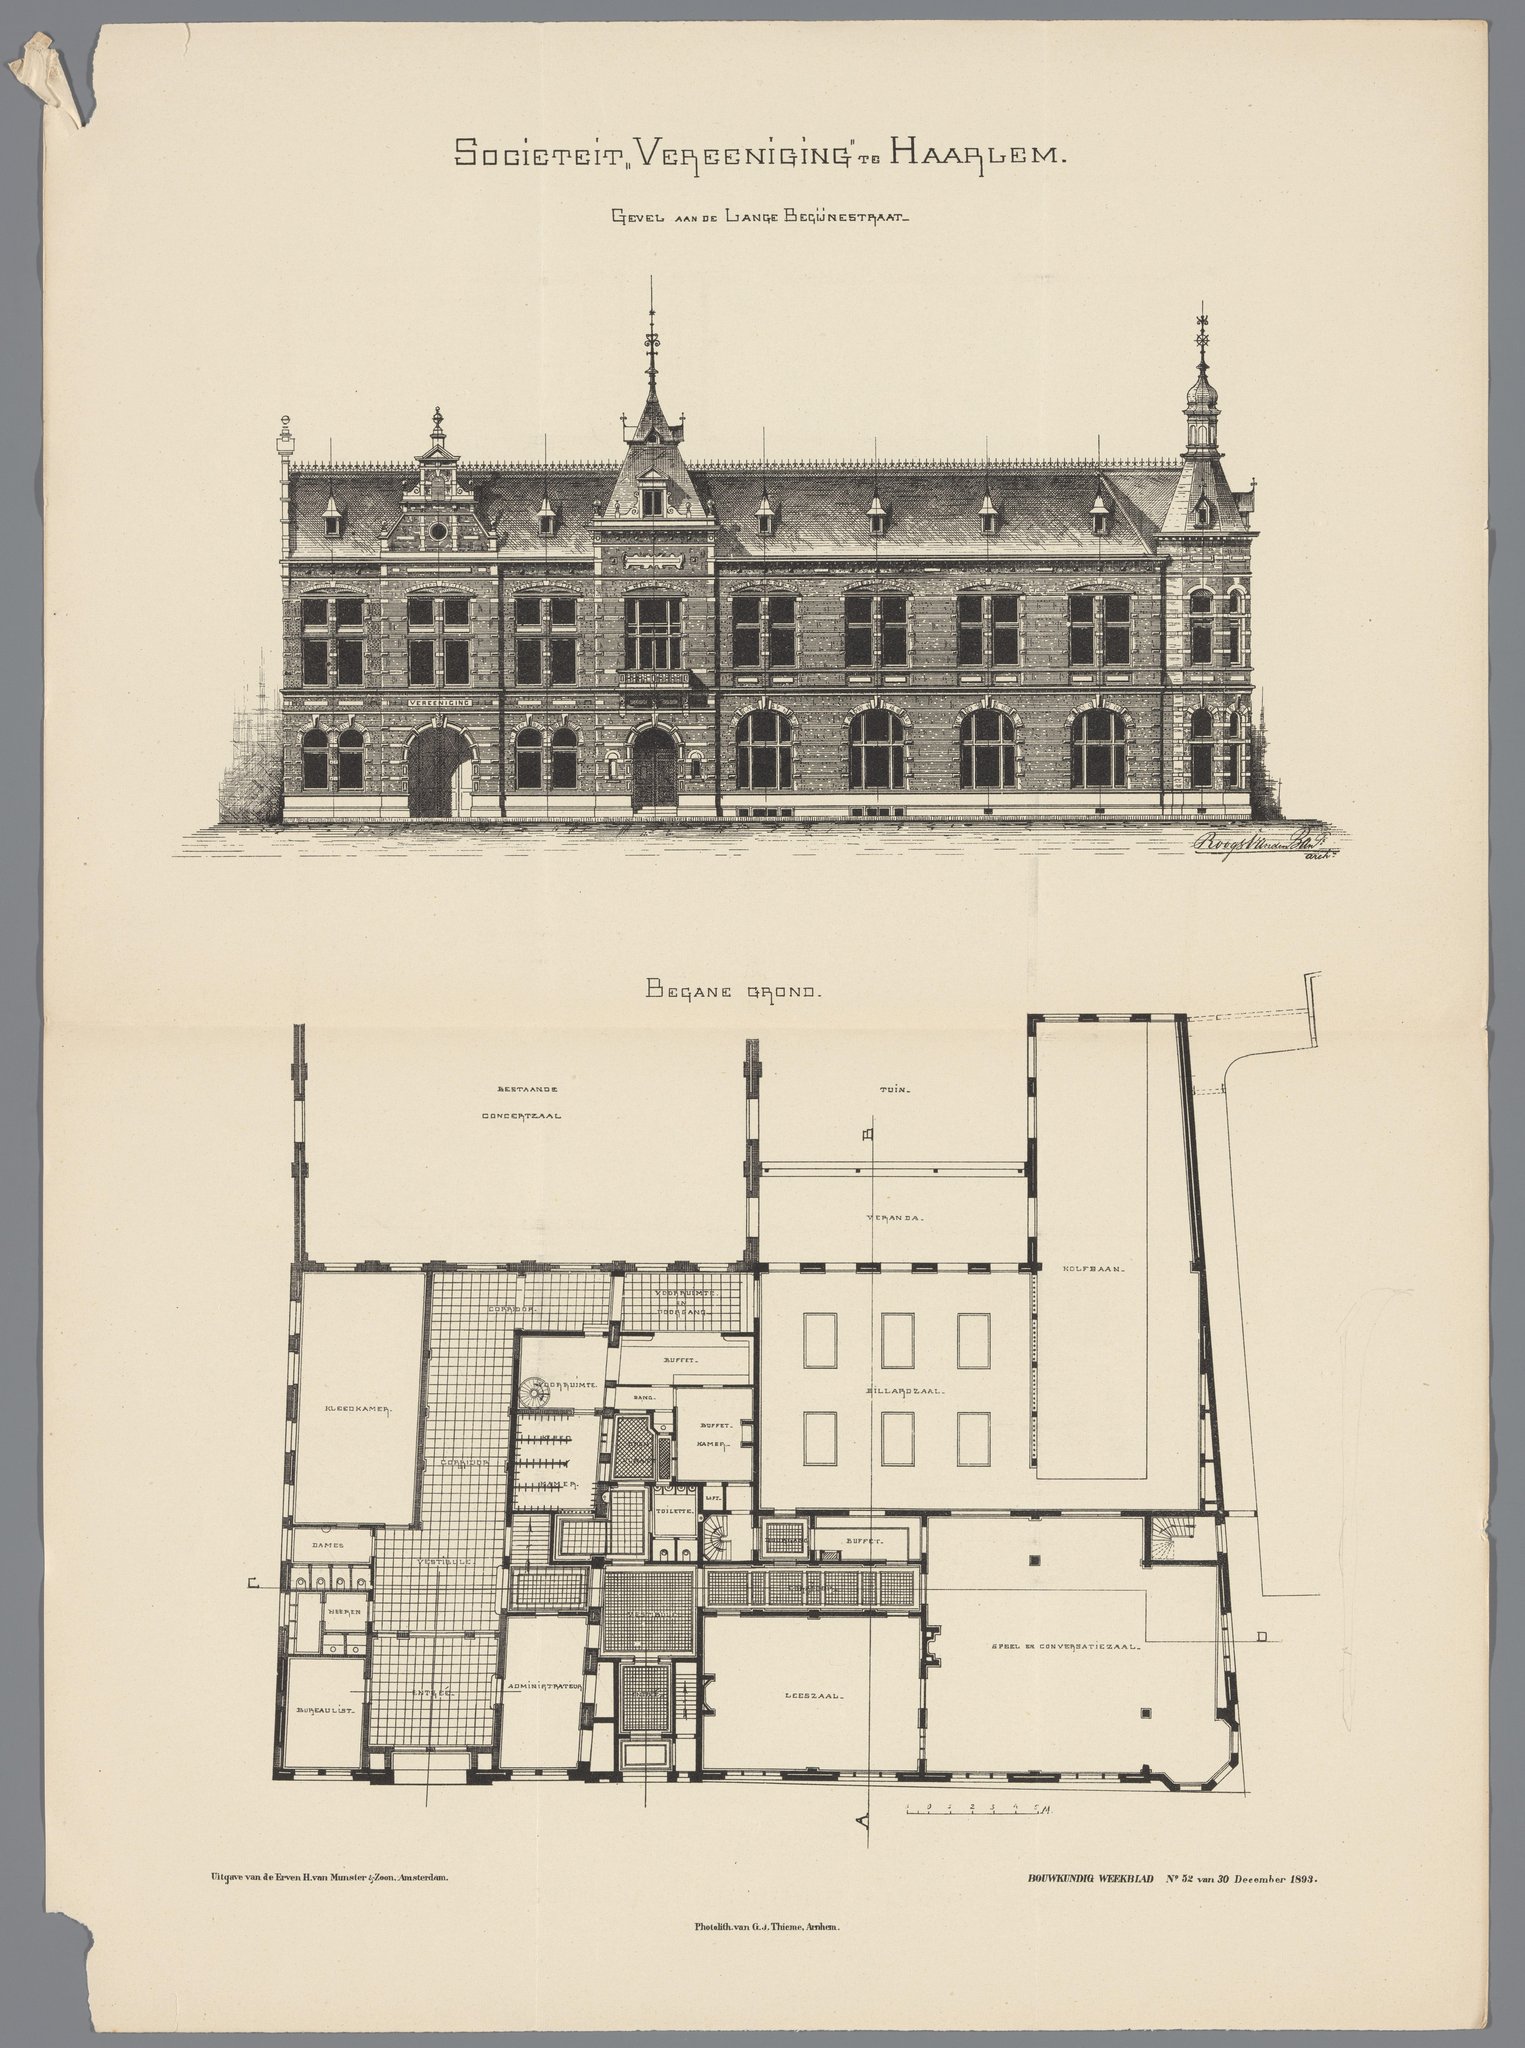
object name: book illustration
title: Societeit "Vereeniging" te Haarlem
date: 1893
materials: paper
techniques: photolithography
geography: amsterdam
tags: edifice, e.g.: public building, department store, haarlem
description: Prent uit: Bouwkundig weekblad; Orgaan van de Maatschappij tot Bevordering der Bouwkunst. Amsterdam: Erven H. Munster & Zoon, 1881-1927, 13e jaargang (1893), nr. 52, na p. 314.